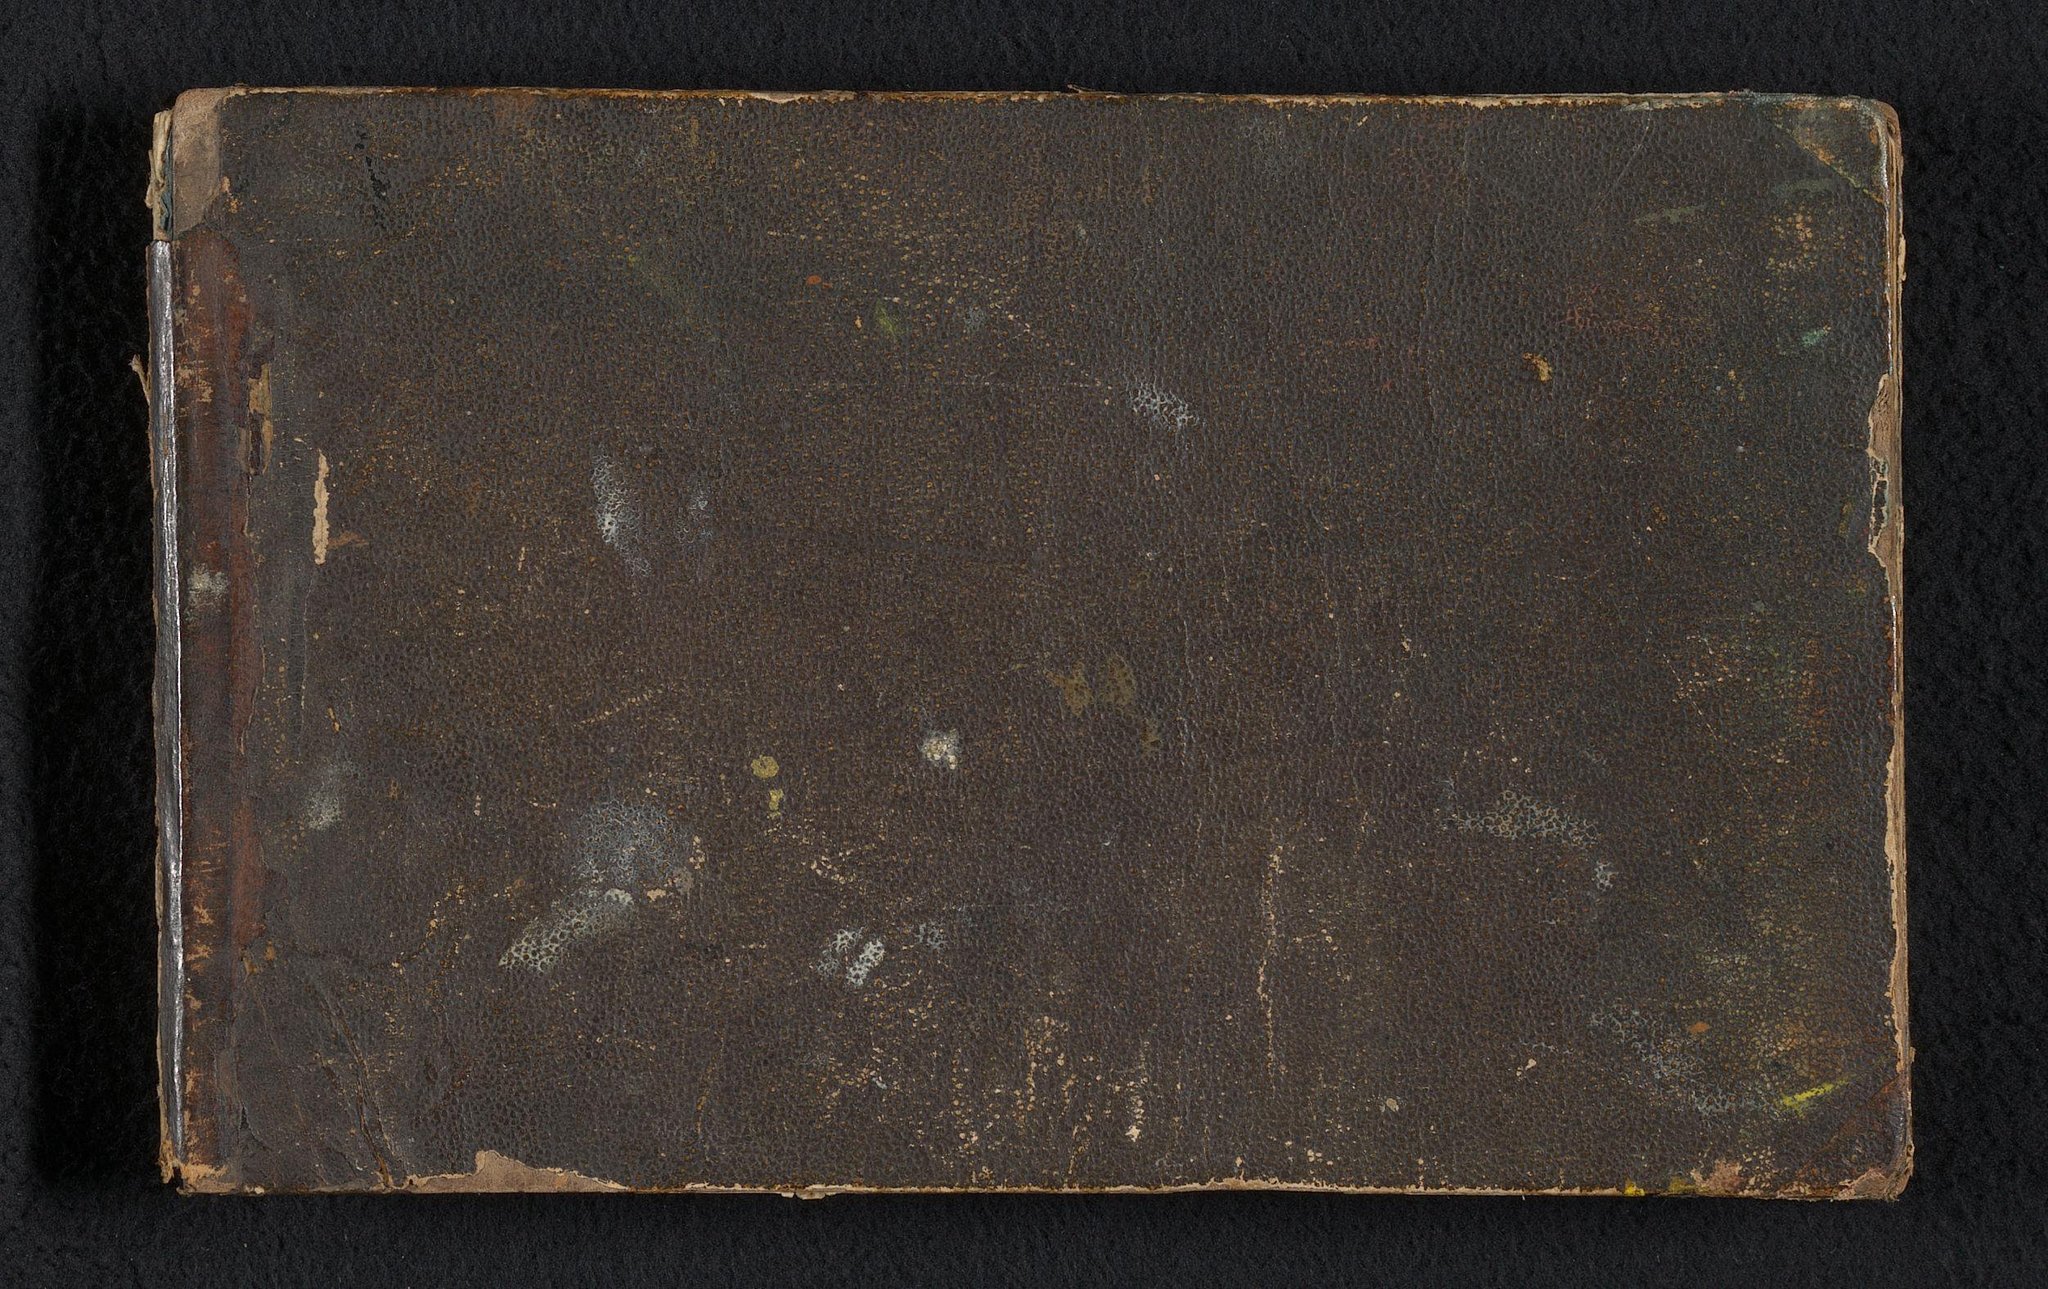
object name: sketchbook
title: Schetsboek met 54 bladen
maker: jan bedijs tom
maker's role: draughtsman, painter, print maker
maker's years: 1813-1894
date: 1828-1894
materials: cardboard, leather, paper, pencil, watercolor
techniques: brush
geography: the hague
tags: landscapes, cattle, landscape with ruins, artist (in general) making preliminary designs, sketching, farm (building)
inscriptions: inscription: ‘[...] 800 / [...] 150 / [...] 2[...]’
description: De volgende recto-bladen uit het schetsboek zijn blanco: 20(R), 22(R) 24(R), 25(R), 28(R) t/m 31(R), 40(R), 42(R), 43(R), 46(R) t/m 51(R), 53(R). De volgende verso-bladen uit het schetsboek zijn blanco: 2(V) t/m 15(V), 25(V), 32(V), 43(V), 44(V).